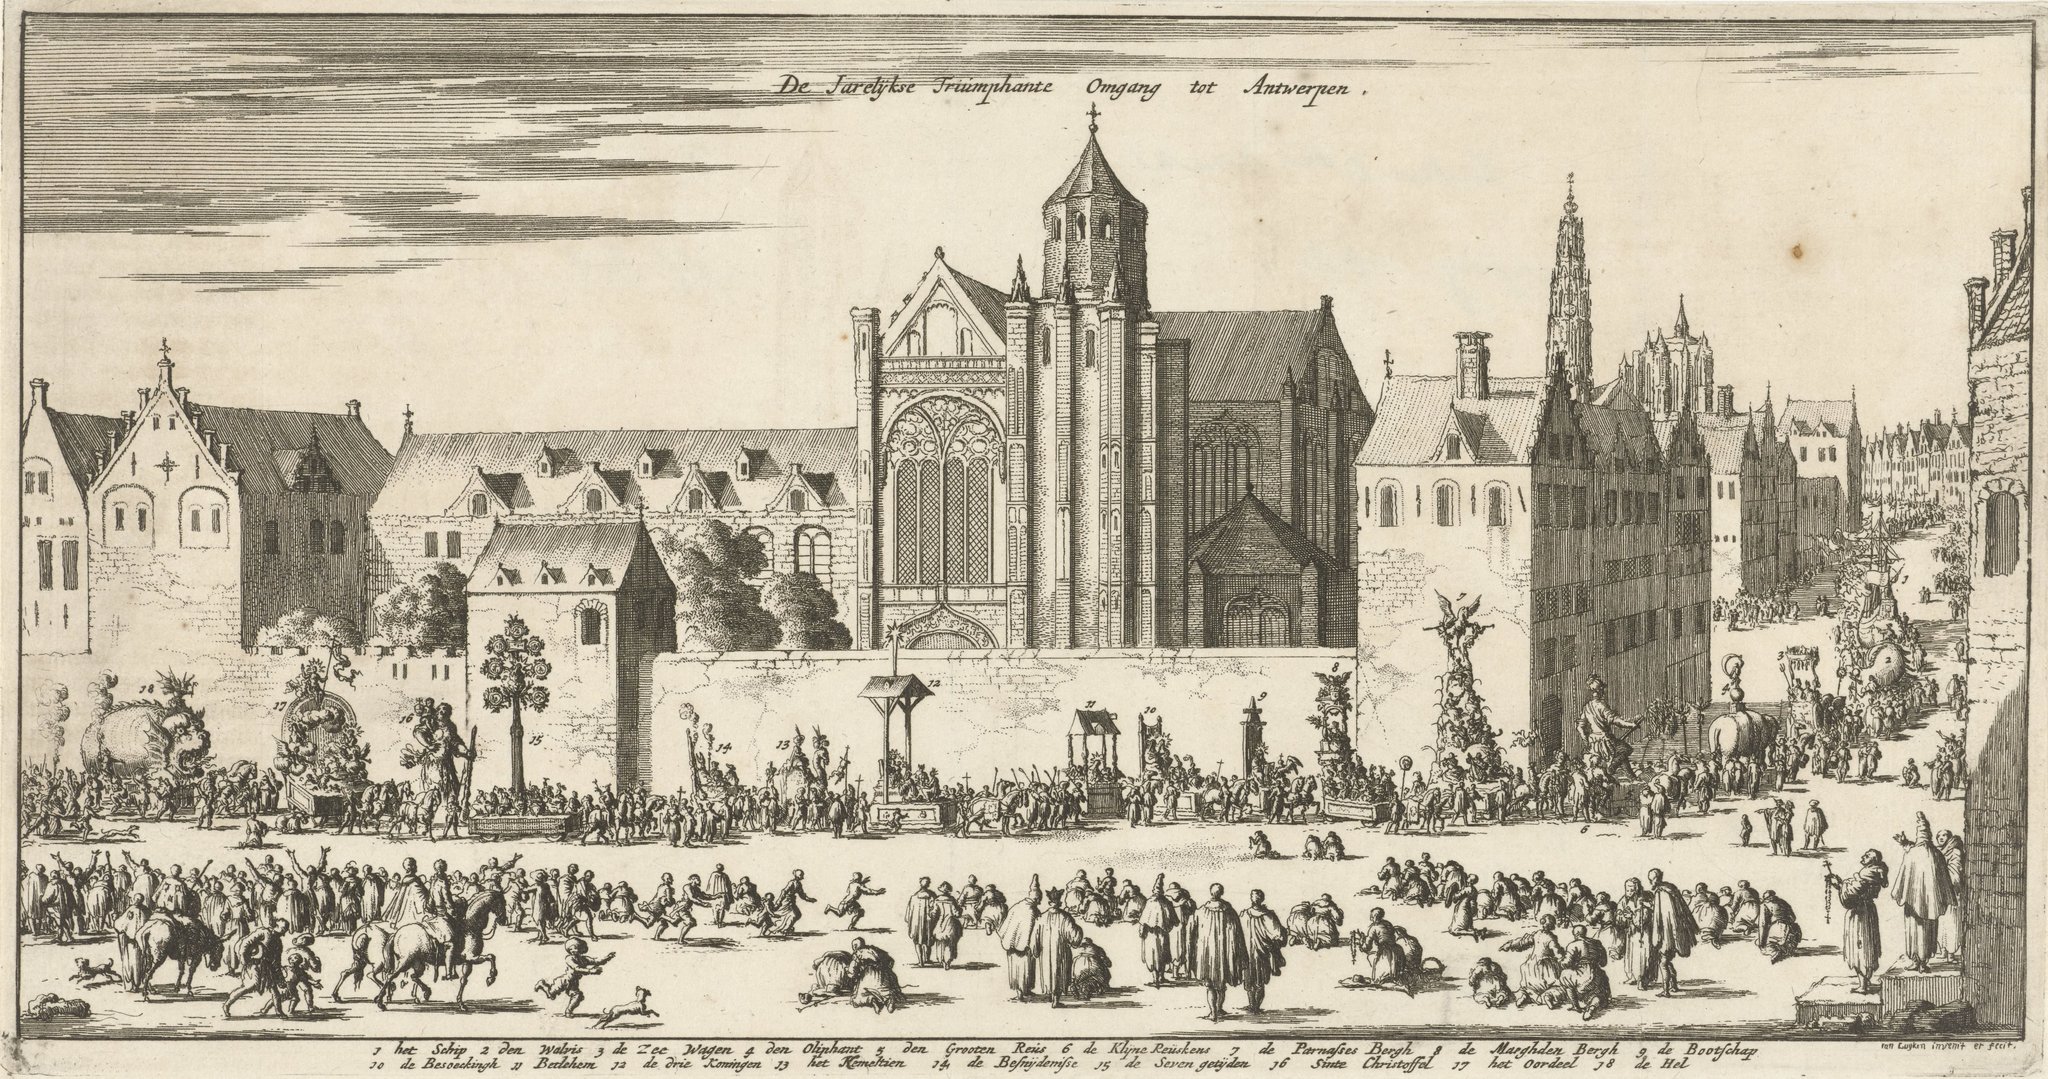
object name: print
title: De Jarelykse Triumphante Omgang tot Antwerpen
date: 1682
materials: paper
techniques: etching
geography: amsterdam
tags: festivities on events of national importance (+ decorated float, wagon ~ festive activities), antwerp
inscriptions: collector's mark: Lugt 2228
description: Jaarlijkse ommegang te Antwerpen, ca. 1680-1681. Een stoet van praalwagens met allegorische voorstellingen trekt door de straten van Antwerpen langs een kerk tussen knielende toeschouwers. In de stoet bevinden zich wagens met voorstellingen van: de Walvis, de reus Antigoon, de Parnassus, Betlehem, de Drie Koningen, het Laatste Oordeel en de Hel. In het onderschrift de legenda 1-18.